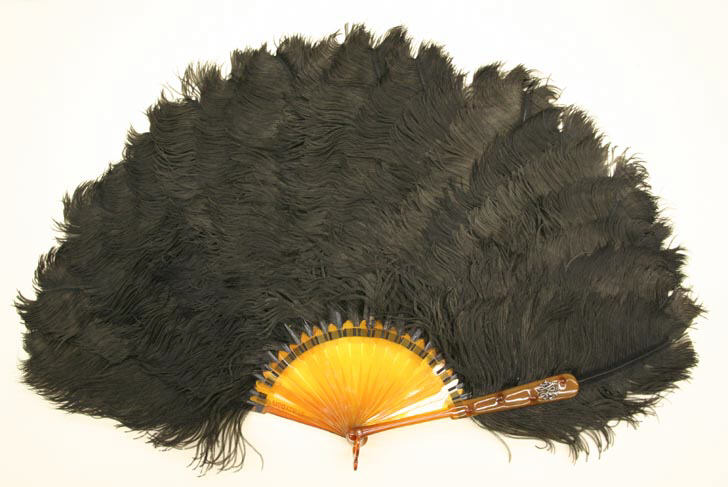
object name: fan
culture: american or european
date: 1890-1899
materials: feather, glass, metal, plastic